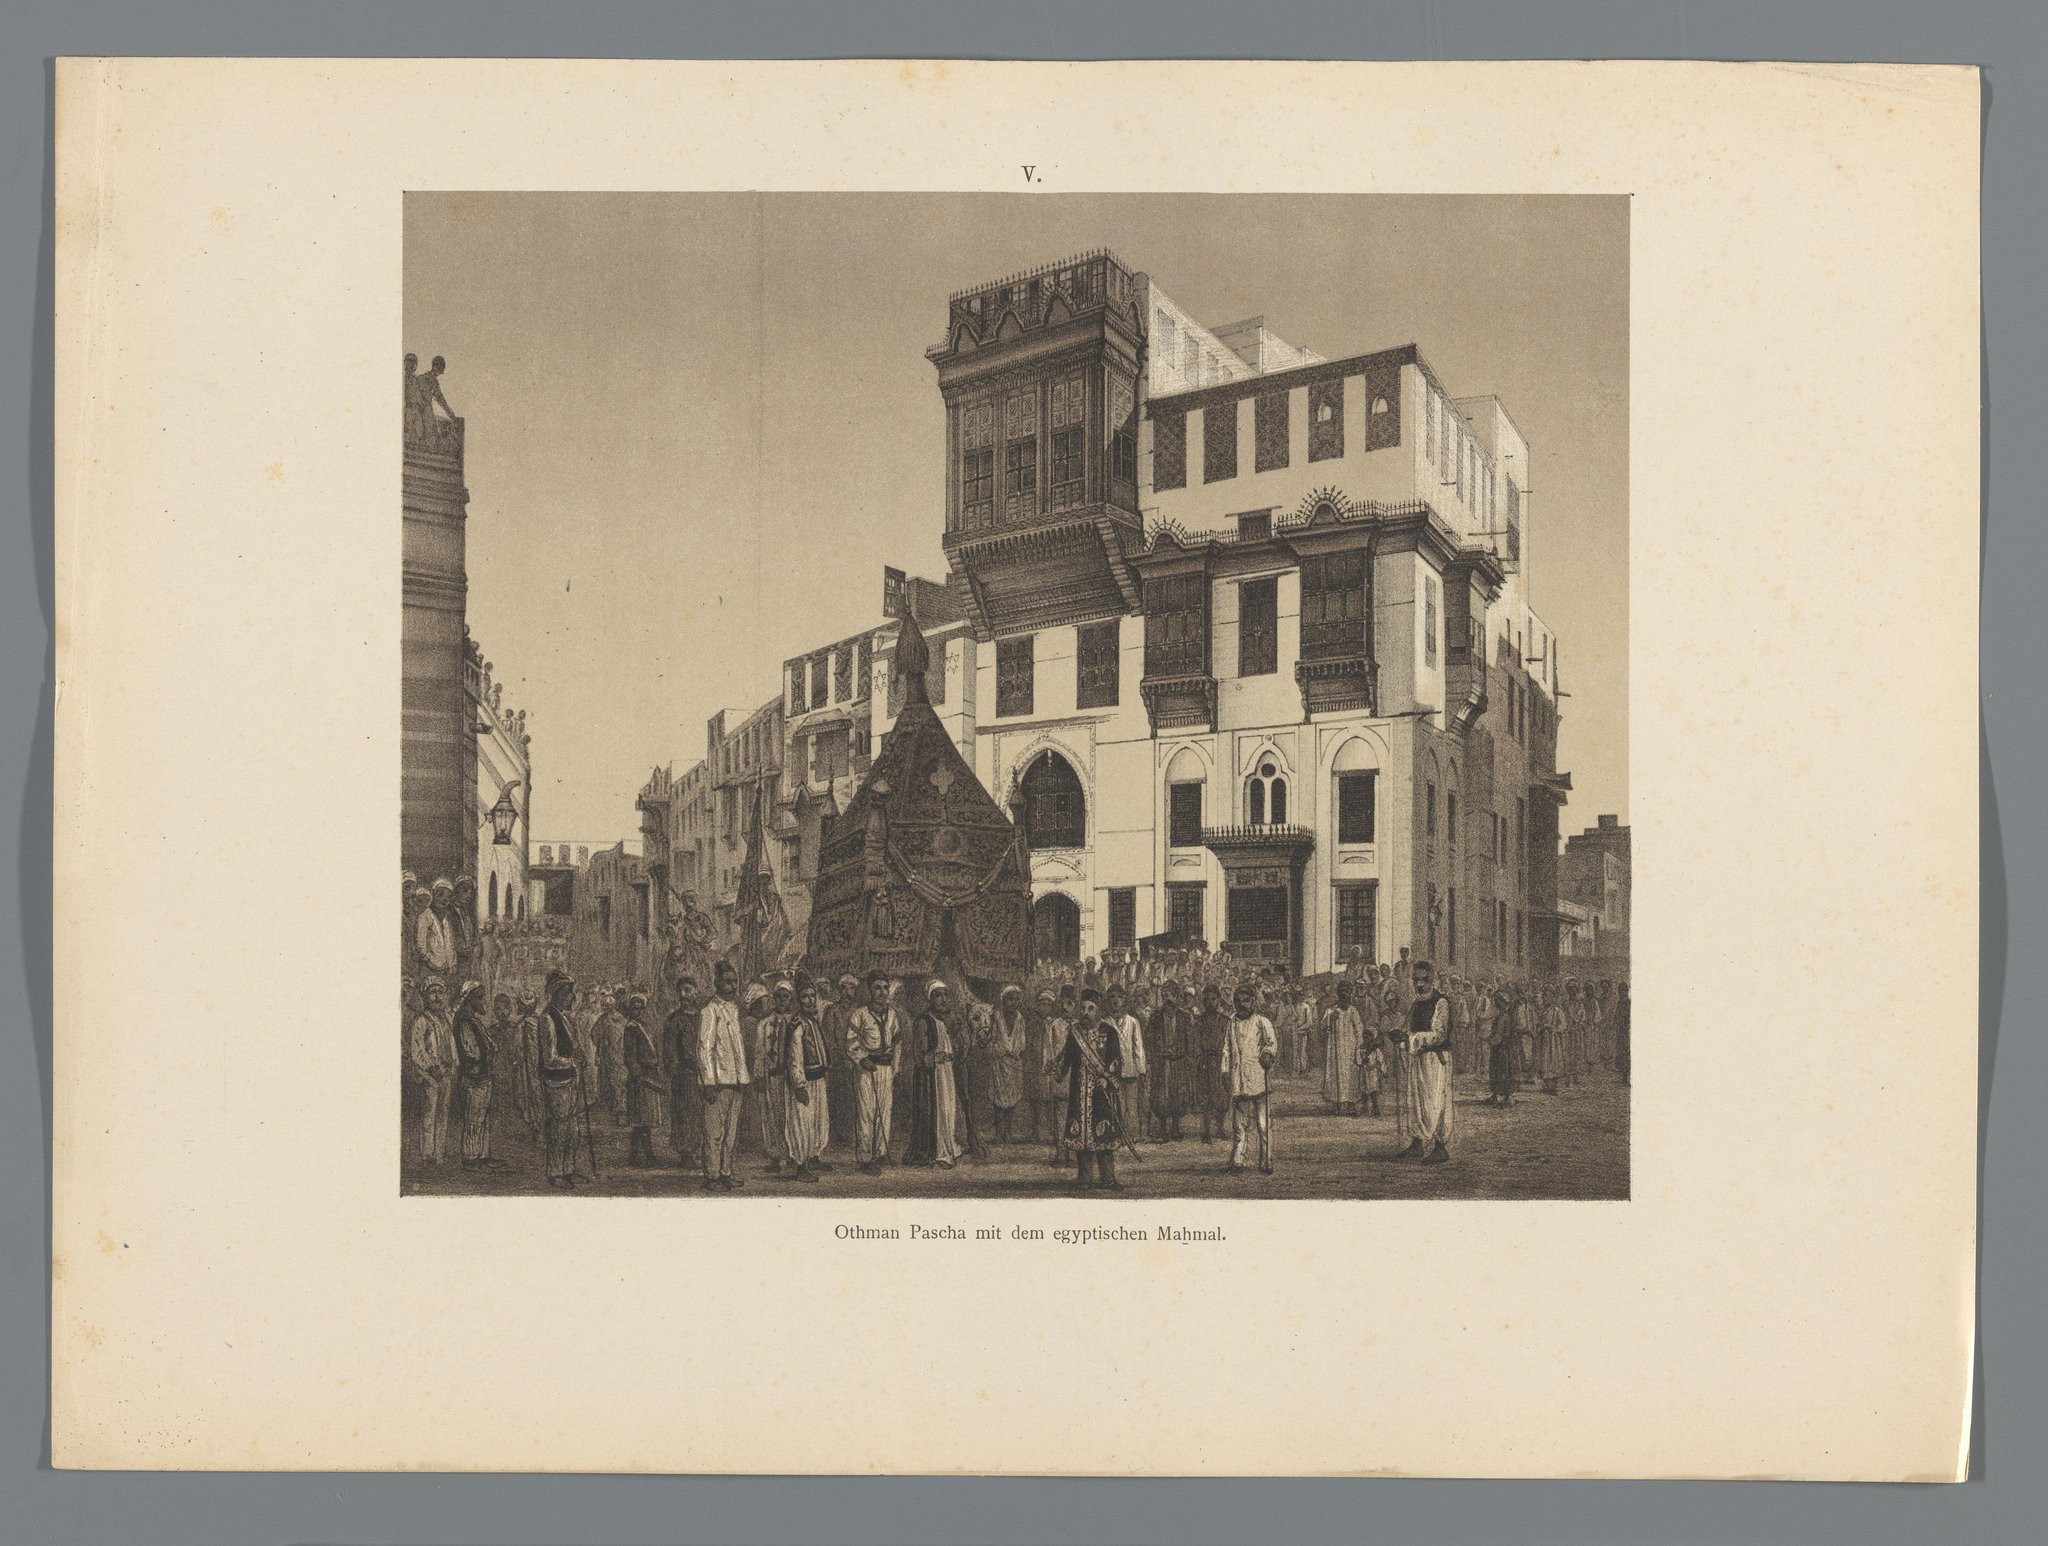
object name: page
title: Optocht in Mekka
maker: Anonymous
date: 1883-1888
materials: paper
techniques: lithograph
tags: public festivities, temple, shrine ~ islam, mohammedanism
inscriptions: number: ‘V.’